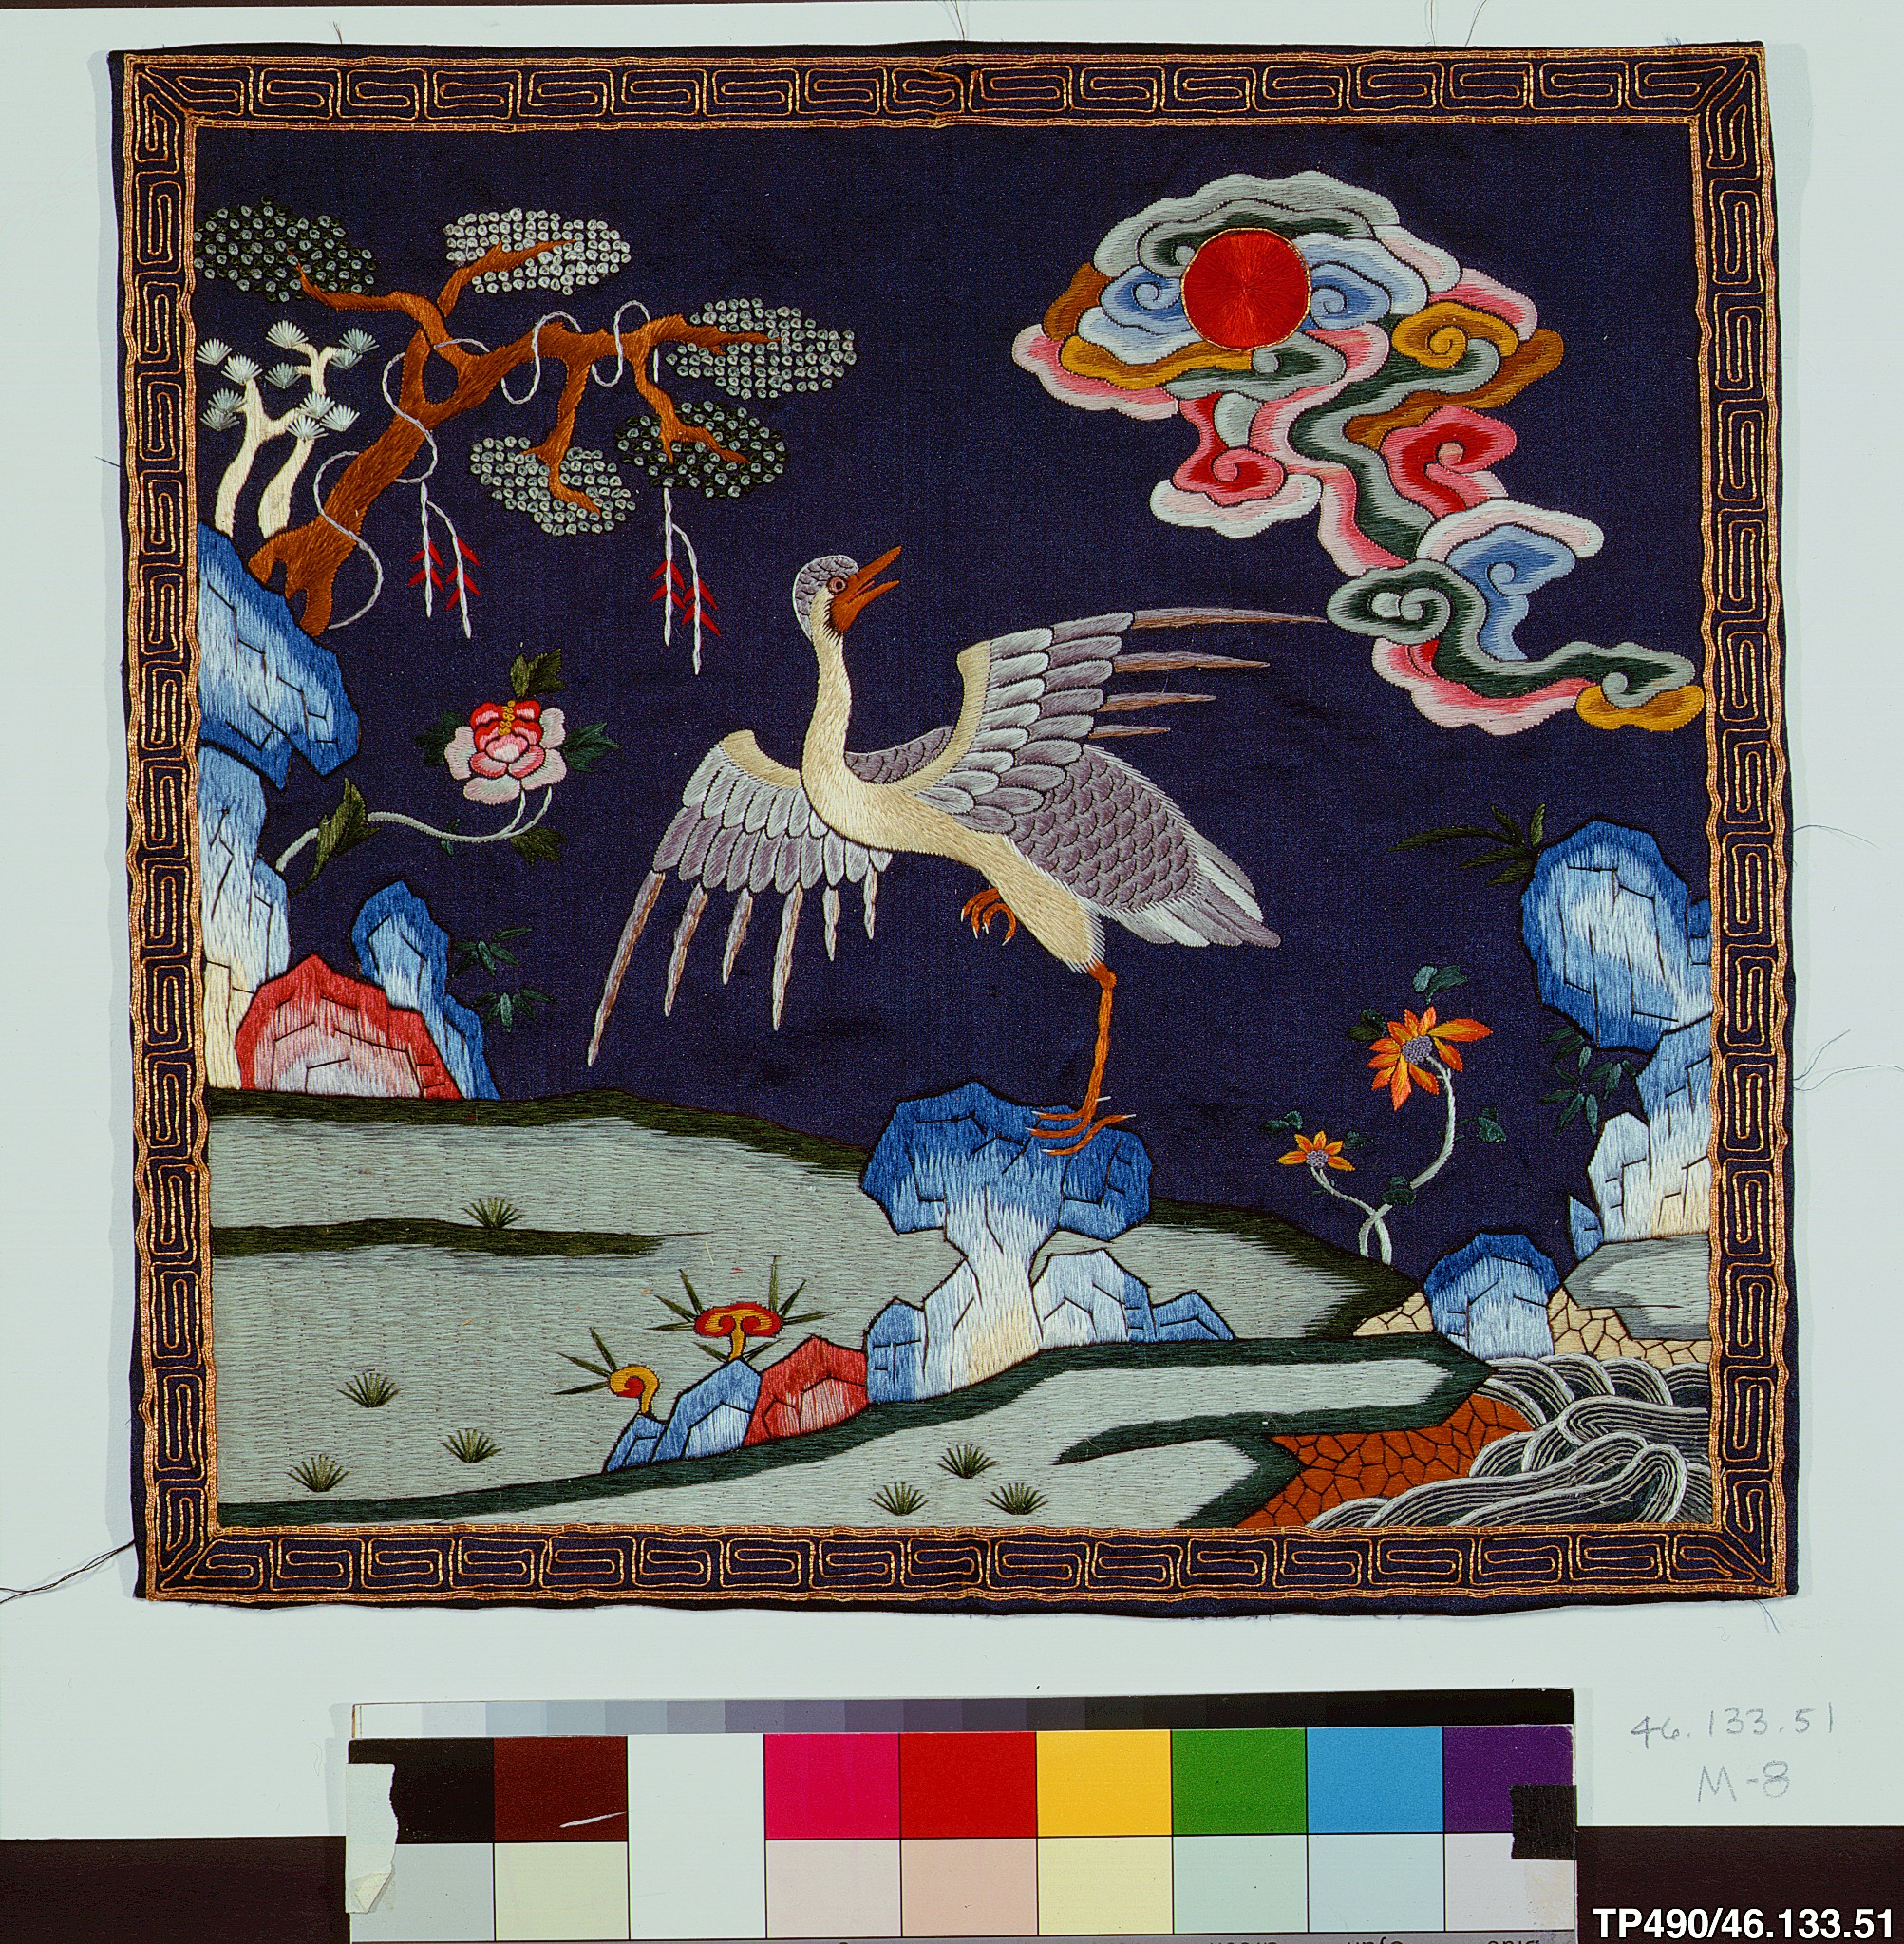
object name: rank badge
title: Rank Badge with Wild Goose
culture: chinese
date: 1723-1735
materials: metal thread, silk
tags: geese,flowers,trees